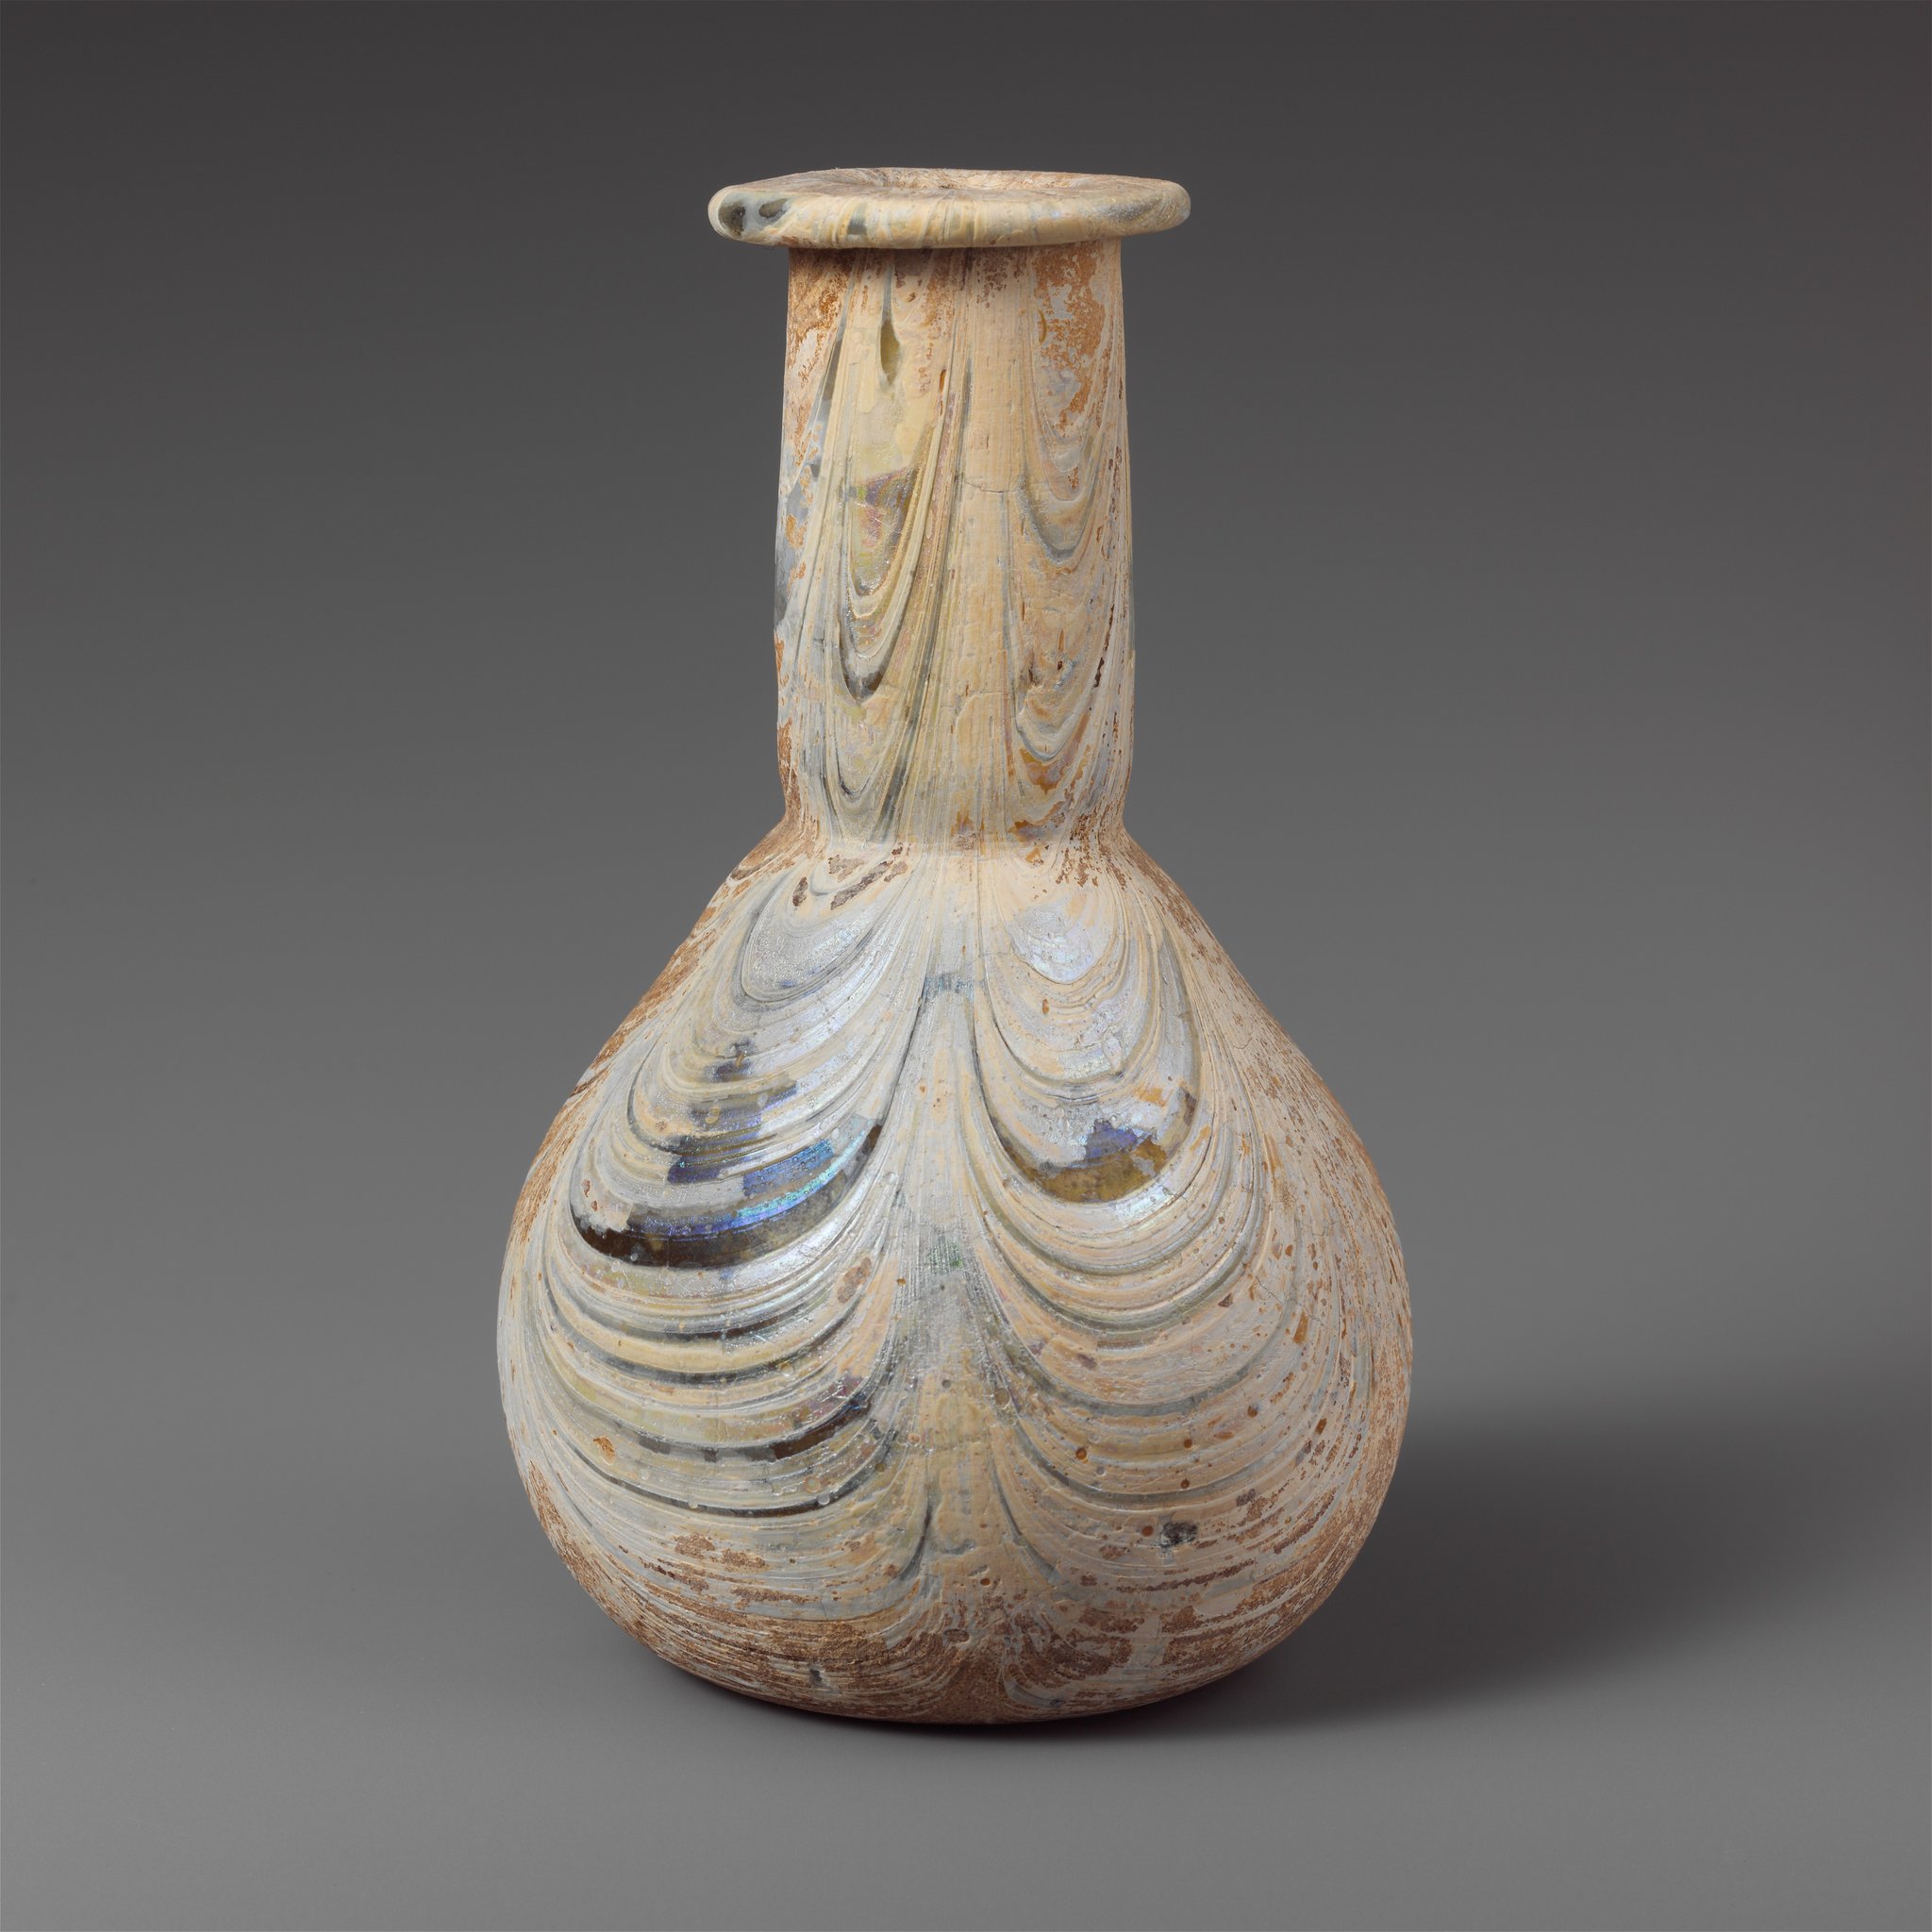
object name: perfume bottle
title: Glass perfume bottle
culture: roman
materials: glass